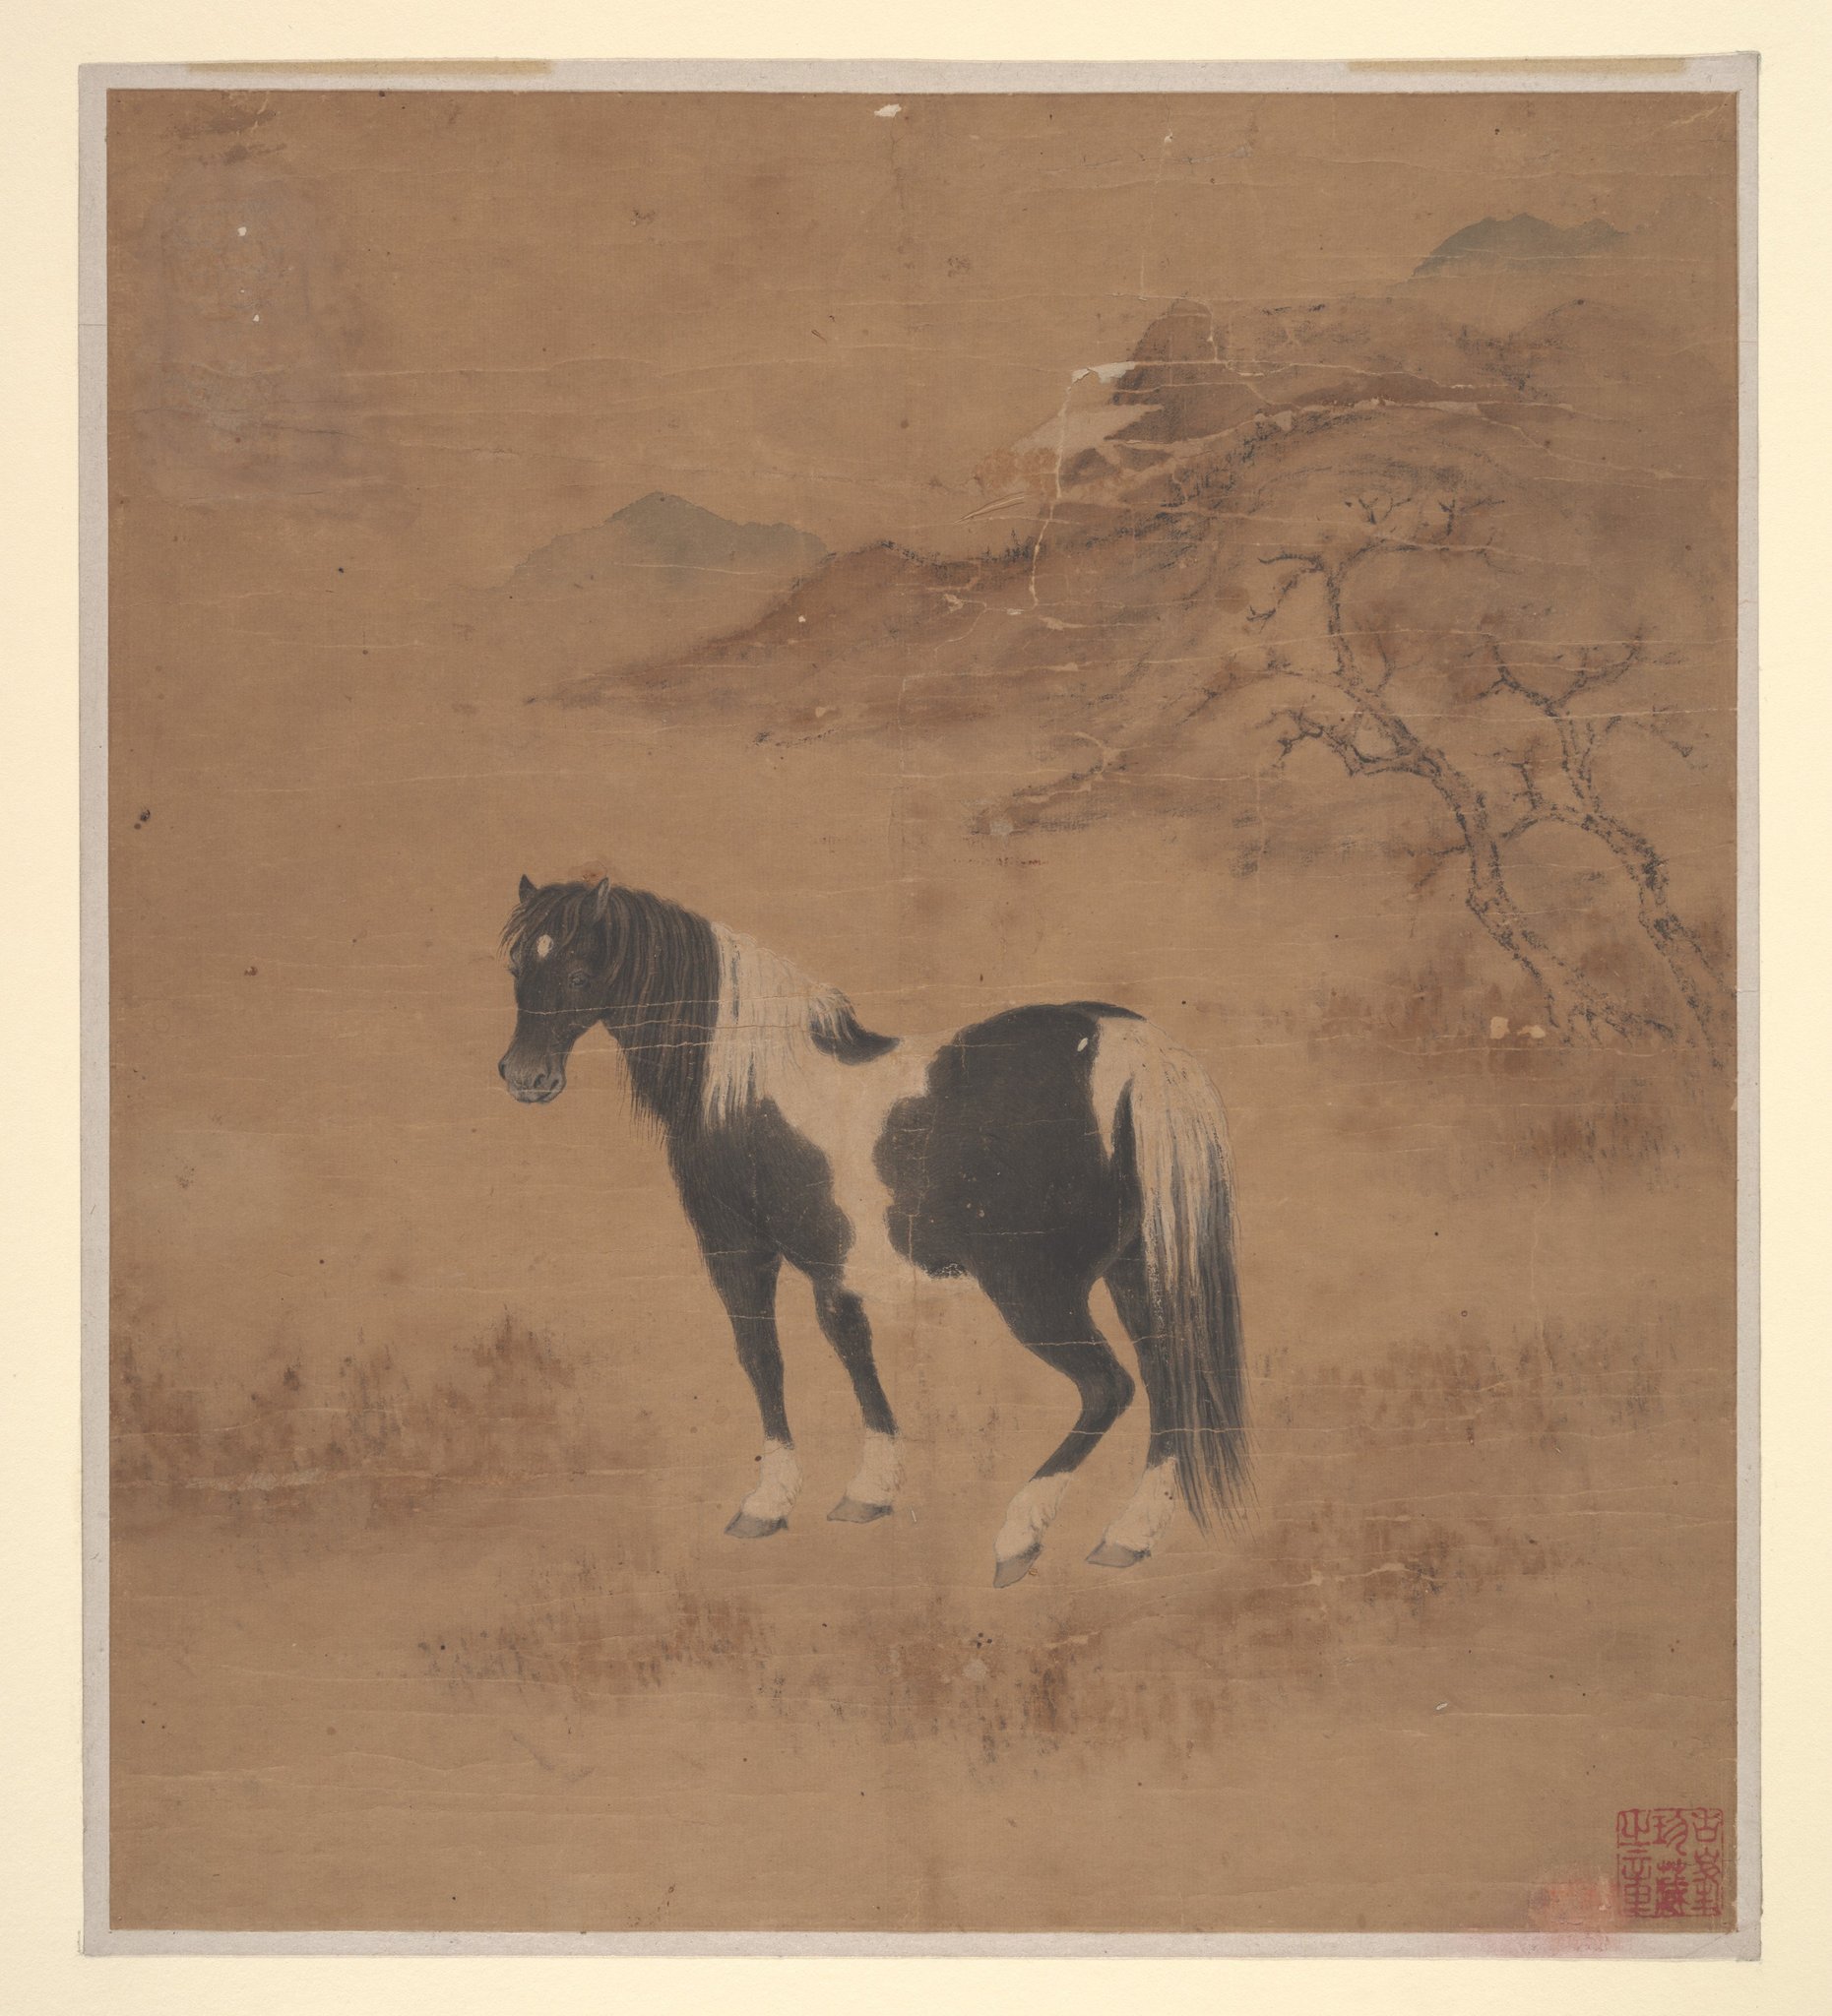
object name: album leaf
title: Horse and Landscape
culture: chinese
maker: unidentified artist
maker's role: artist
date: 1644-1911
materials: silk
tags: horses